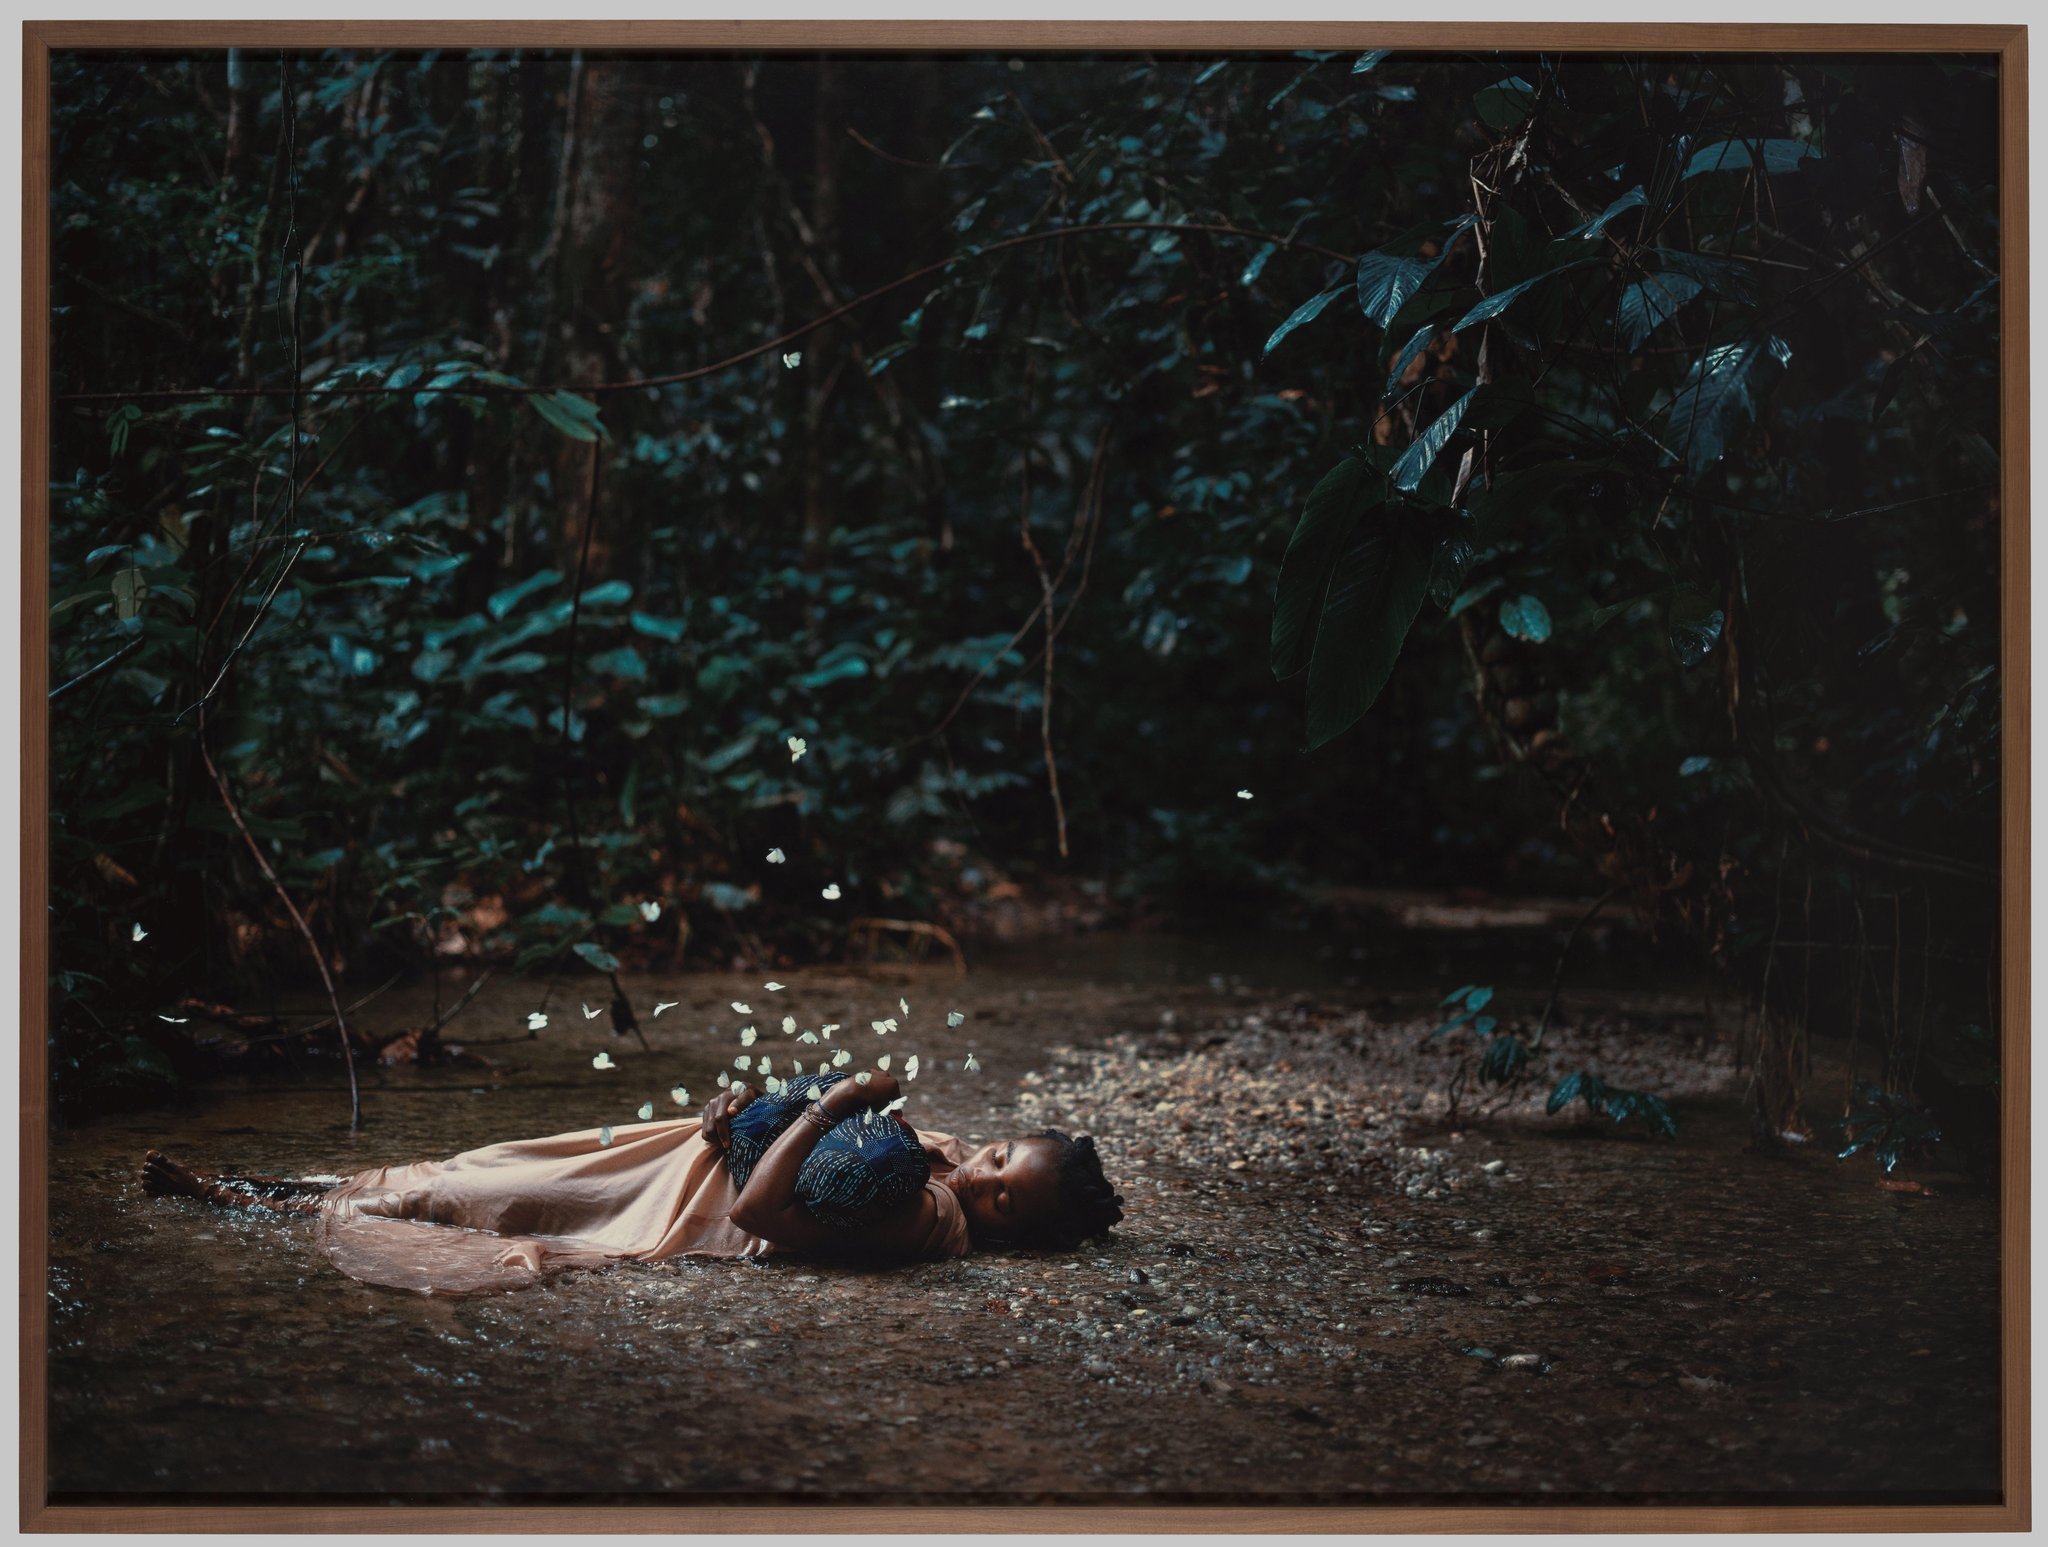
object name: photograph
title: Congo Tales – The Two Nkééngé Sisters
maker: pieter henket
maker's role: fotograaf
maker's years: 1979-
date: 2018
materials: glass, wood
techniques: inkjet print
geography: congo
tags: congo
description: An ancient rainforest myth is part of the Congolese oral tradition. The tale tells of two infertile sisters who would become pregnant if they crossed the forest without glancing back. One sister turned around and gave birth to an ugly boy, the other to a beautiful girl. The first sister swapped babies and drowned her sibling and son, who continued to roam the riverbed like ghosts. With the help of the river crab, the river spirits released them and reunion followed.